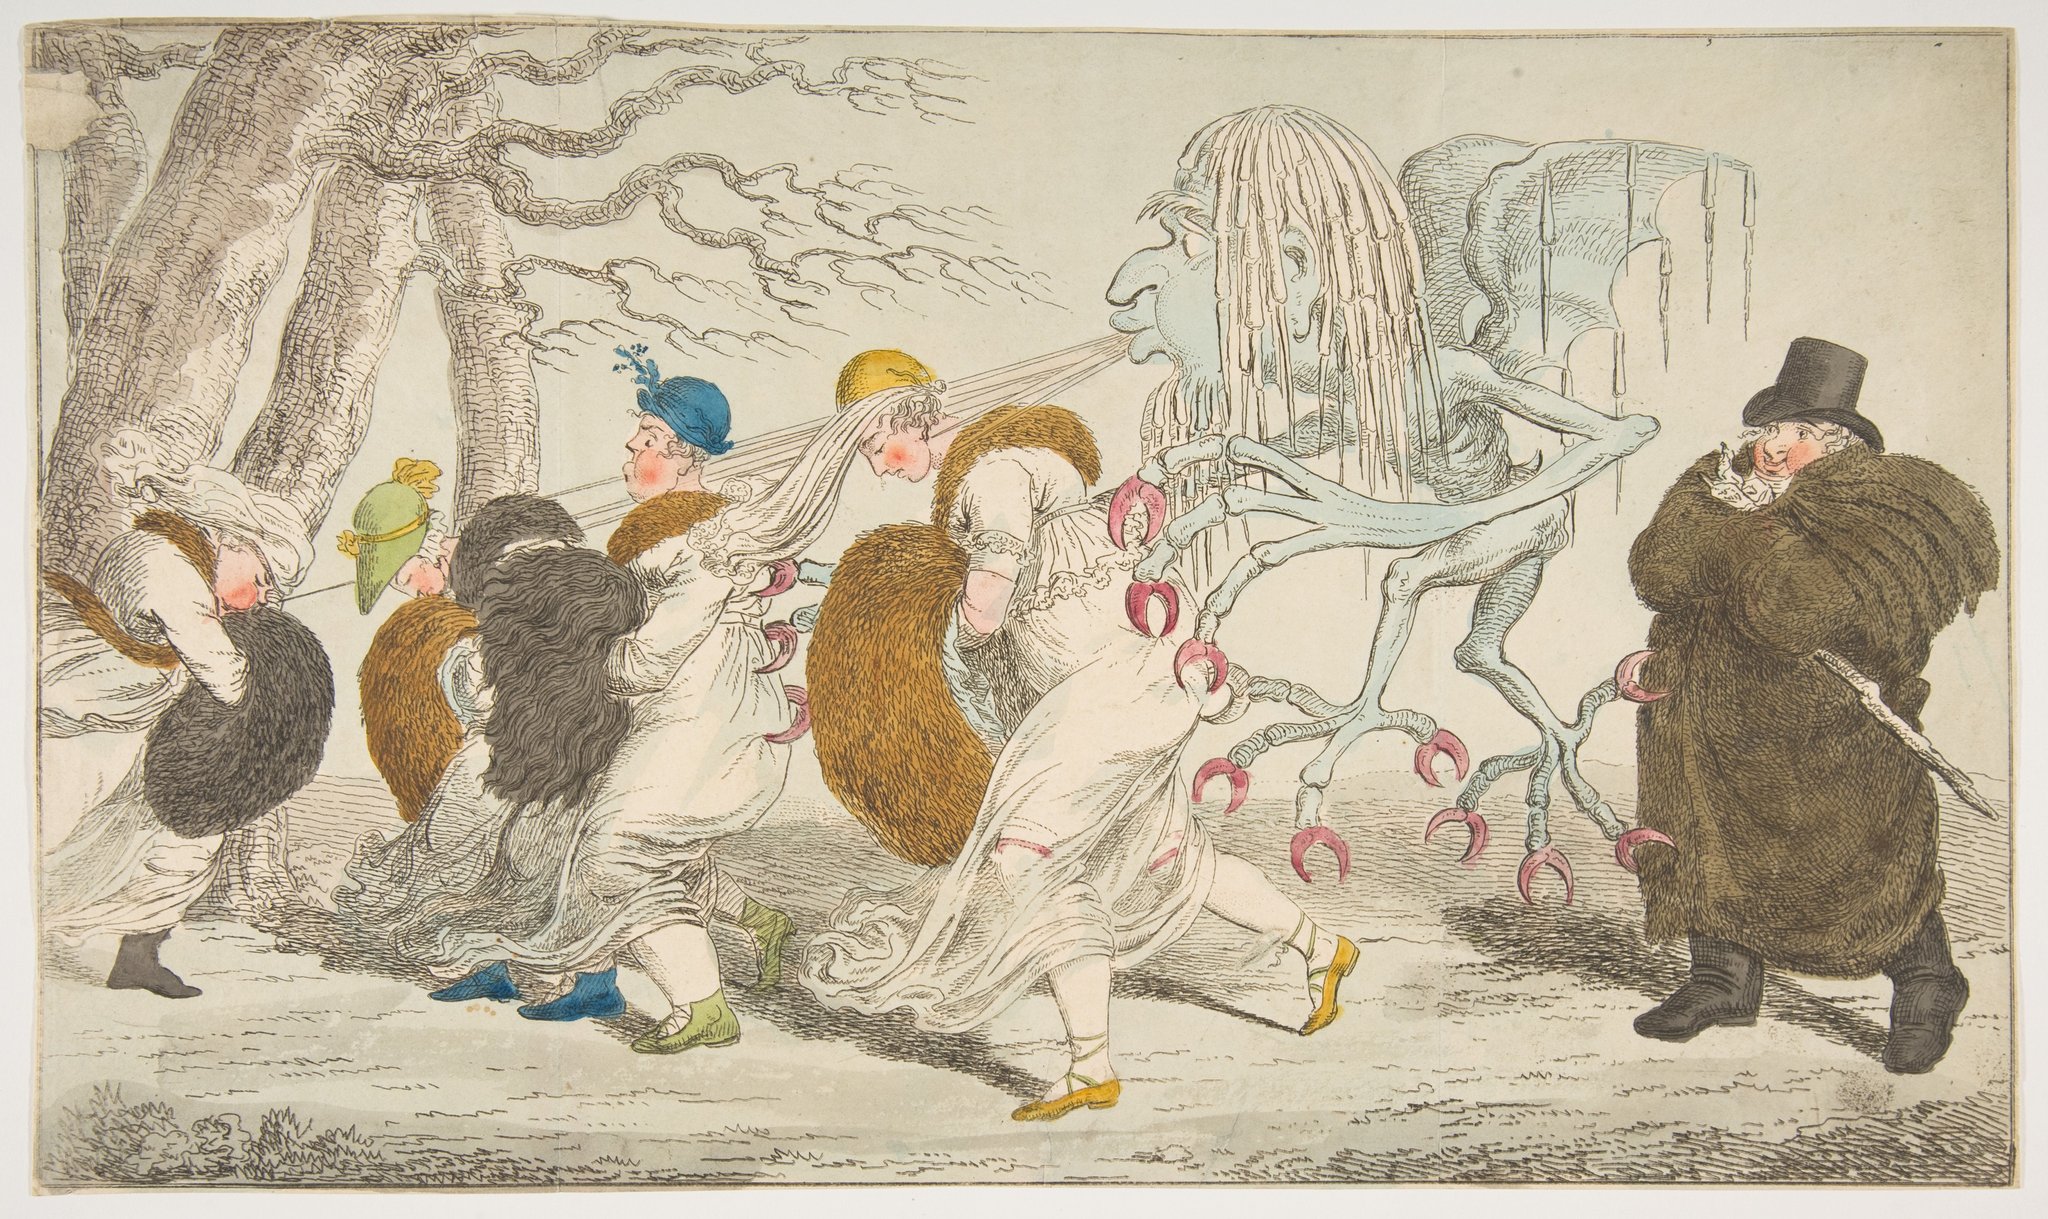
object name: print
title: A Naked Truth, or Nipping Frost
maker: charles williams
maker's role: artist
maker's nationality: british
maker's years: 1750-1850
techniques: etching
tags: satire,men,women,wind